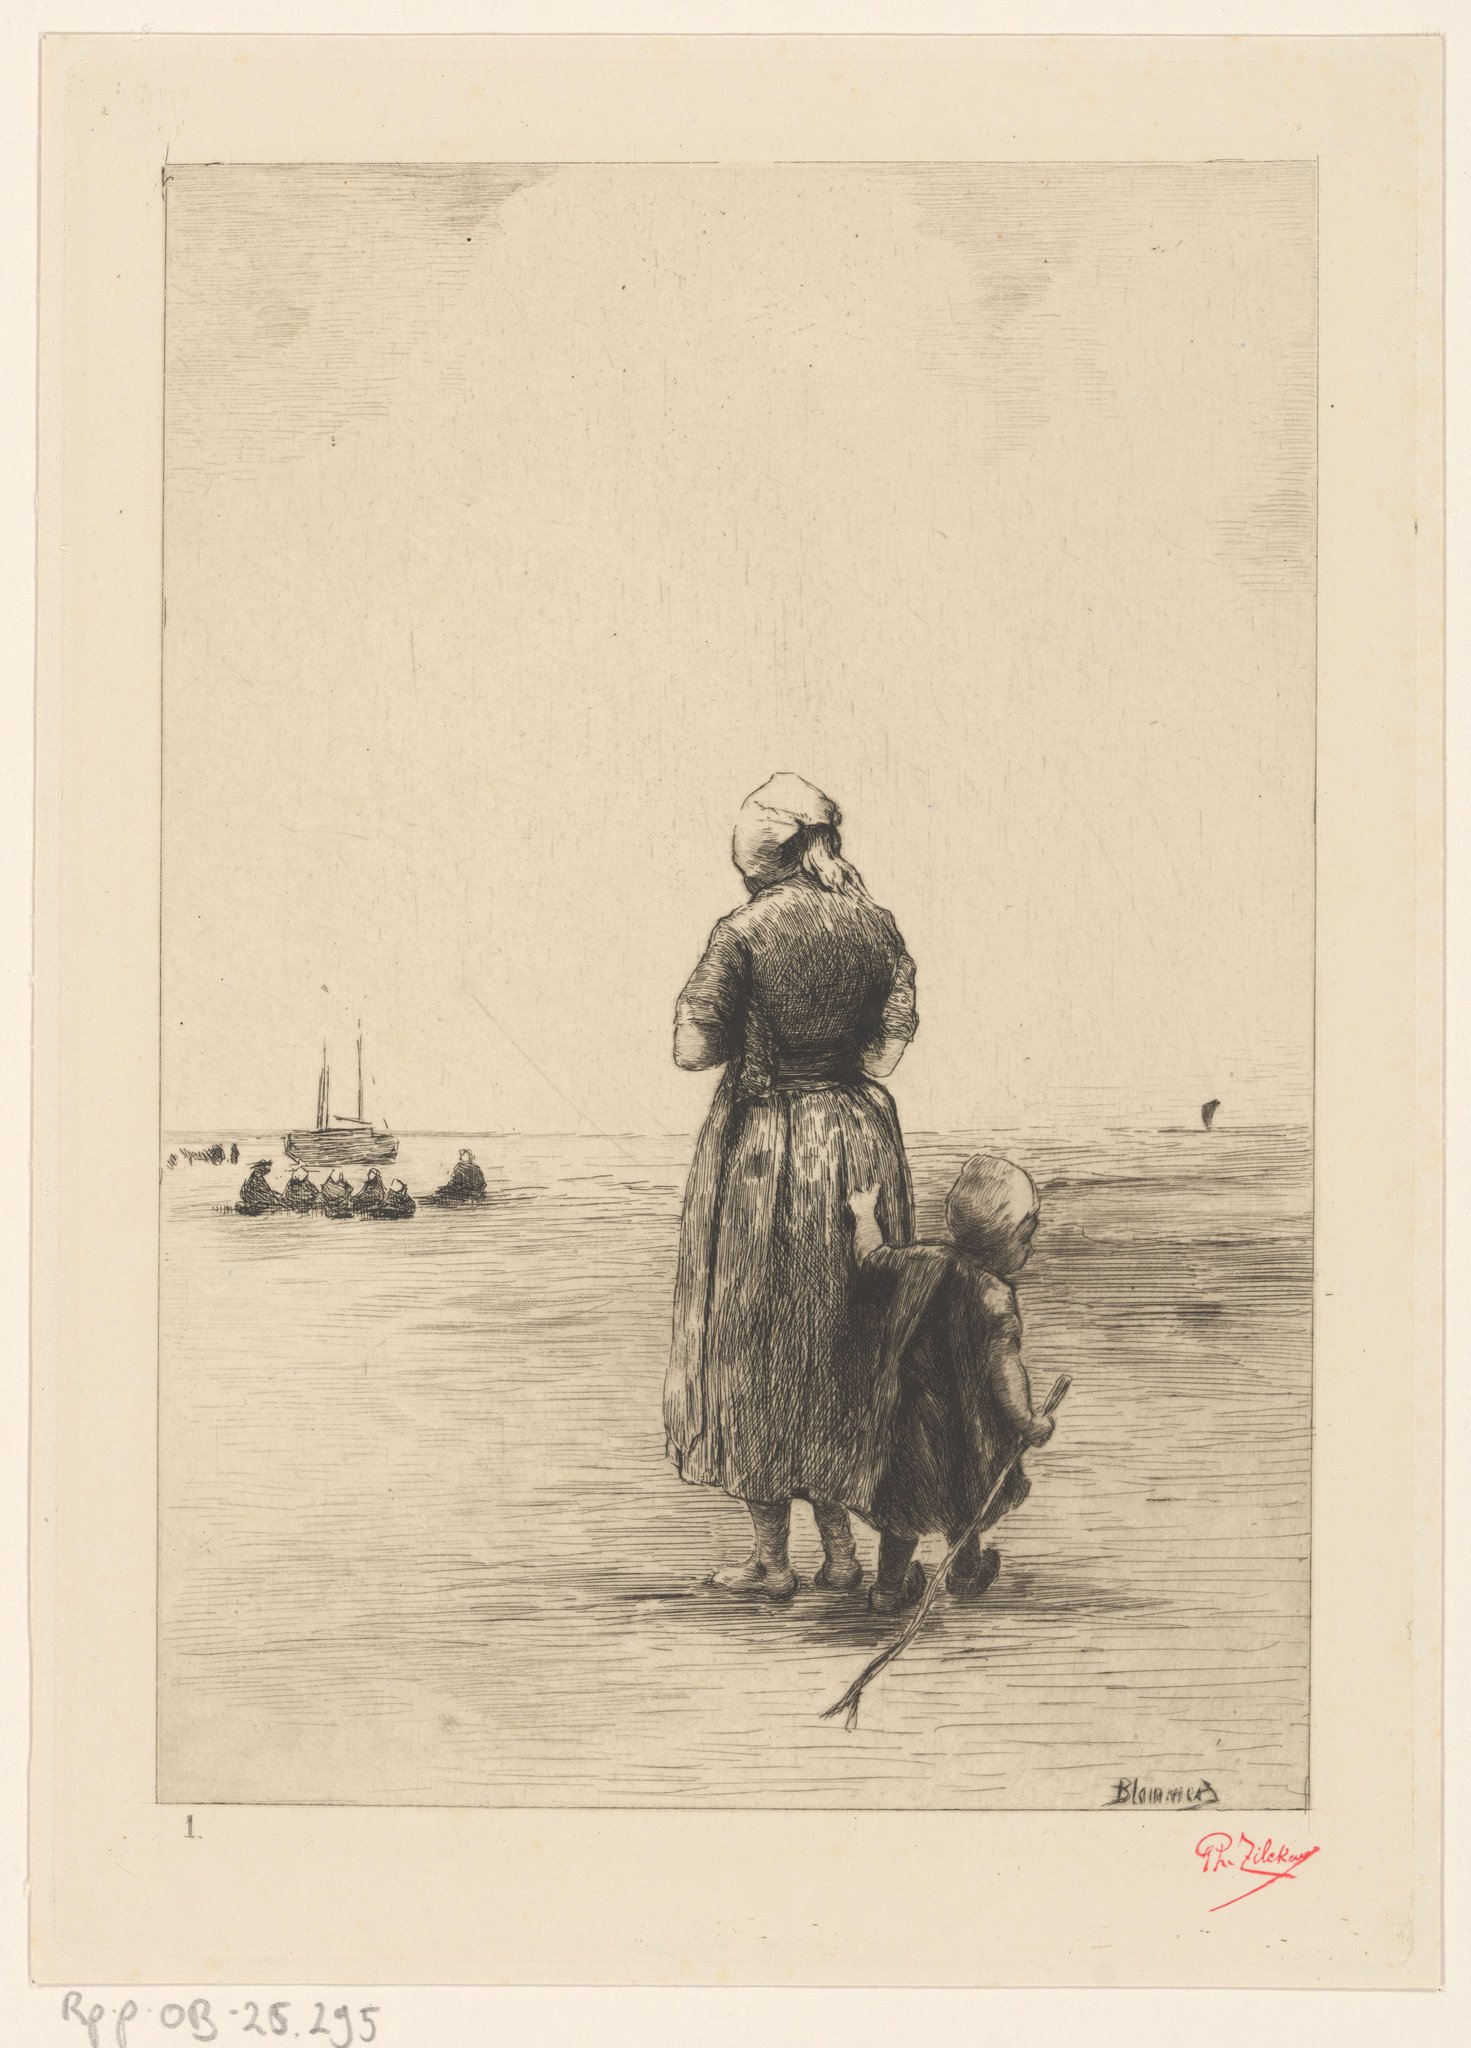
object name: print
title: Sur la plage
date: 1867-1890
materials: paper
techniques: drypoint, etching, intaglio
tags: child, tot, toddler ~ the ages of man, beach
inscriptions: collector's mark: Lugt 2228, number: ‘1’